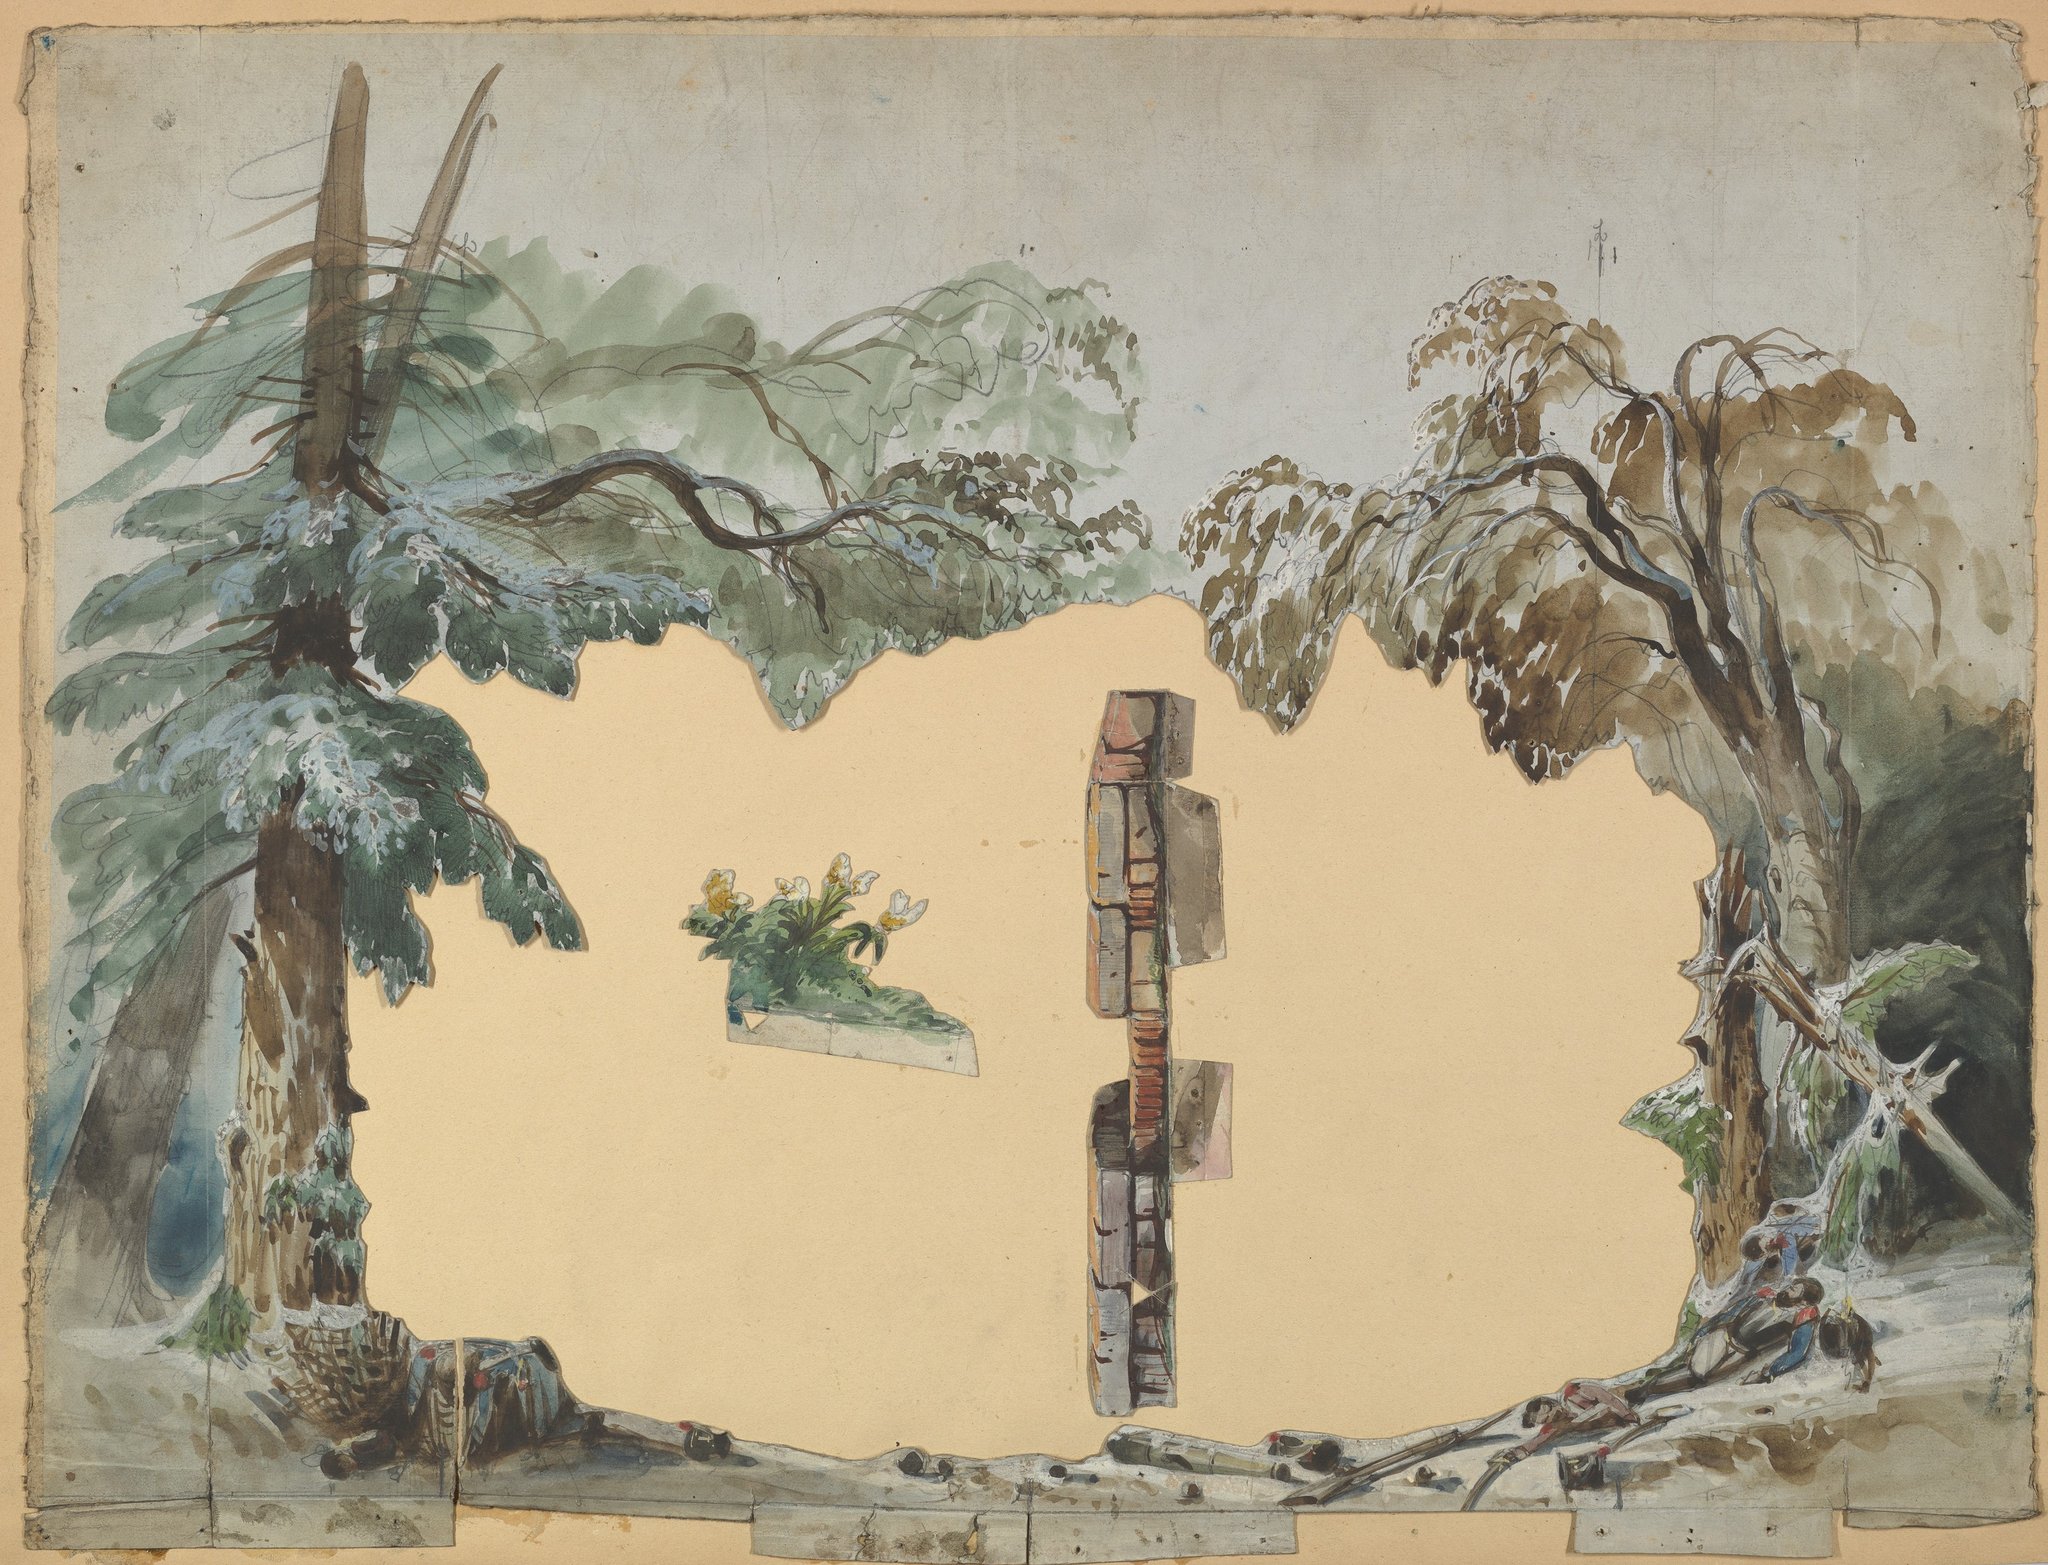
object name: drawing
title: Design for a Stage Set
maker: eugène cicéri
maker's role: artist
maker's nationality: french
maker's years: 1813-1890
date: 1830-1890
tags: trees,stage design